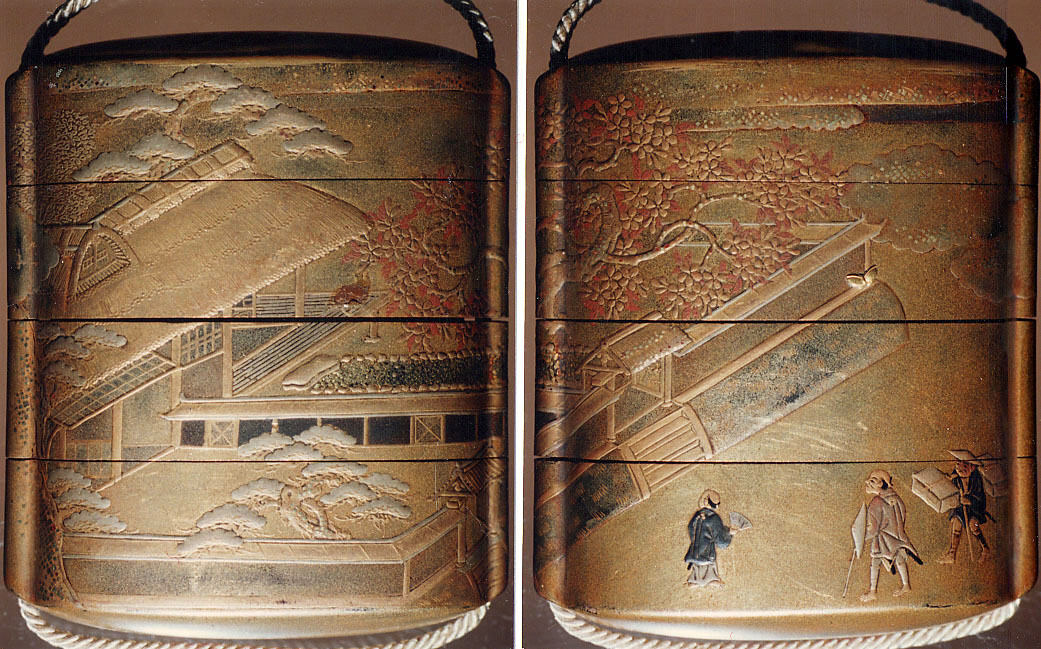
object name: inrō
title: Case (Inrō) with Design of Persons Outside Building and Wall (obverse); With Flowering Cherry Trees (reverse)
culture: japanese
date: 1801-1900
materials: gold, lacquer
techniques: fundame, hiramakie, maki-e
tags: buildings,men